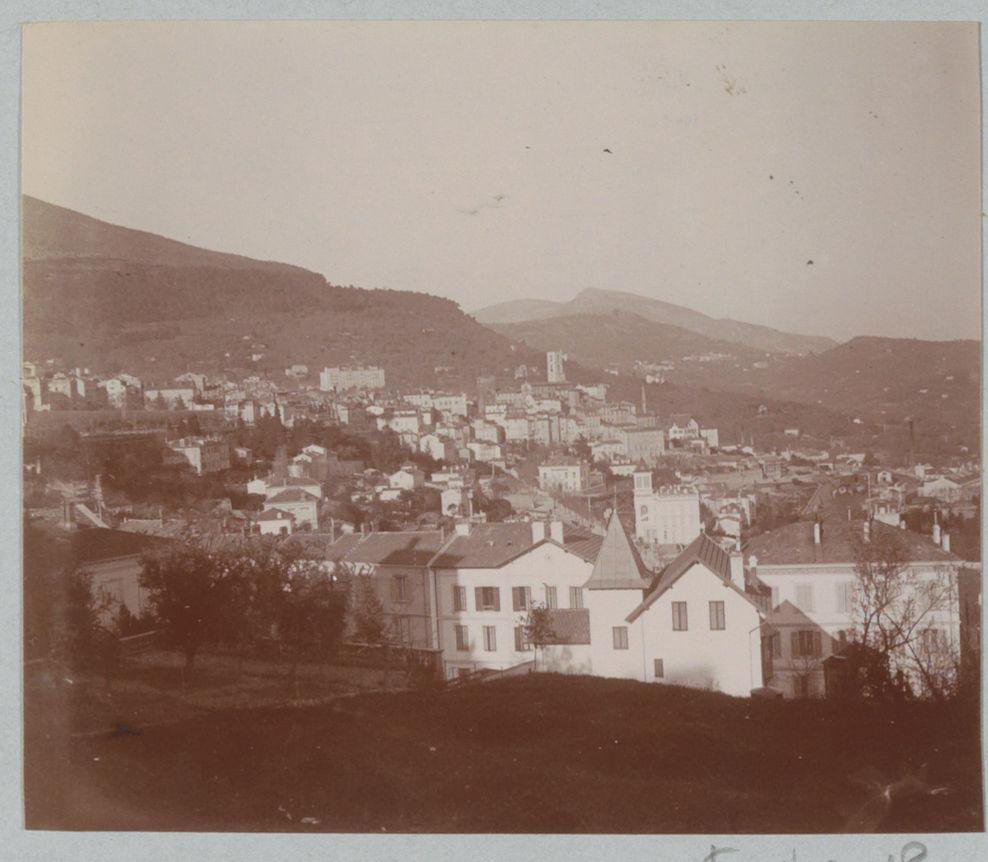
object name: photograph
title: Gezicht op een stad in de bergen, vermoedelijk in Zuid-Frankrijk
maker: Anonymous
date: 1905-1910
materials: paper, photographic support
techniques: gelatin silver print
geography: southern france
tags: prospect of city, town panorama, silhouette of city, mountains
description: Onderdeel van Fotoalbum van een Franse amateurfotograaf met bezienswaardigheden in Frankrijk, Zwitserland en Italië.